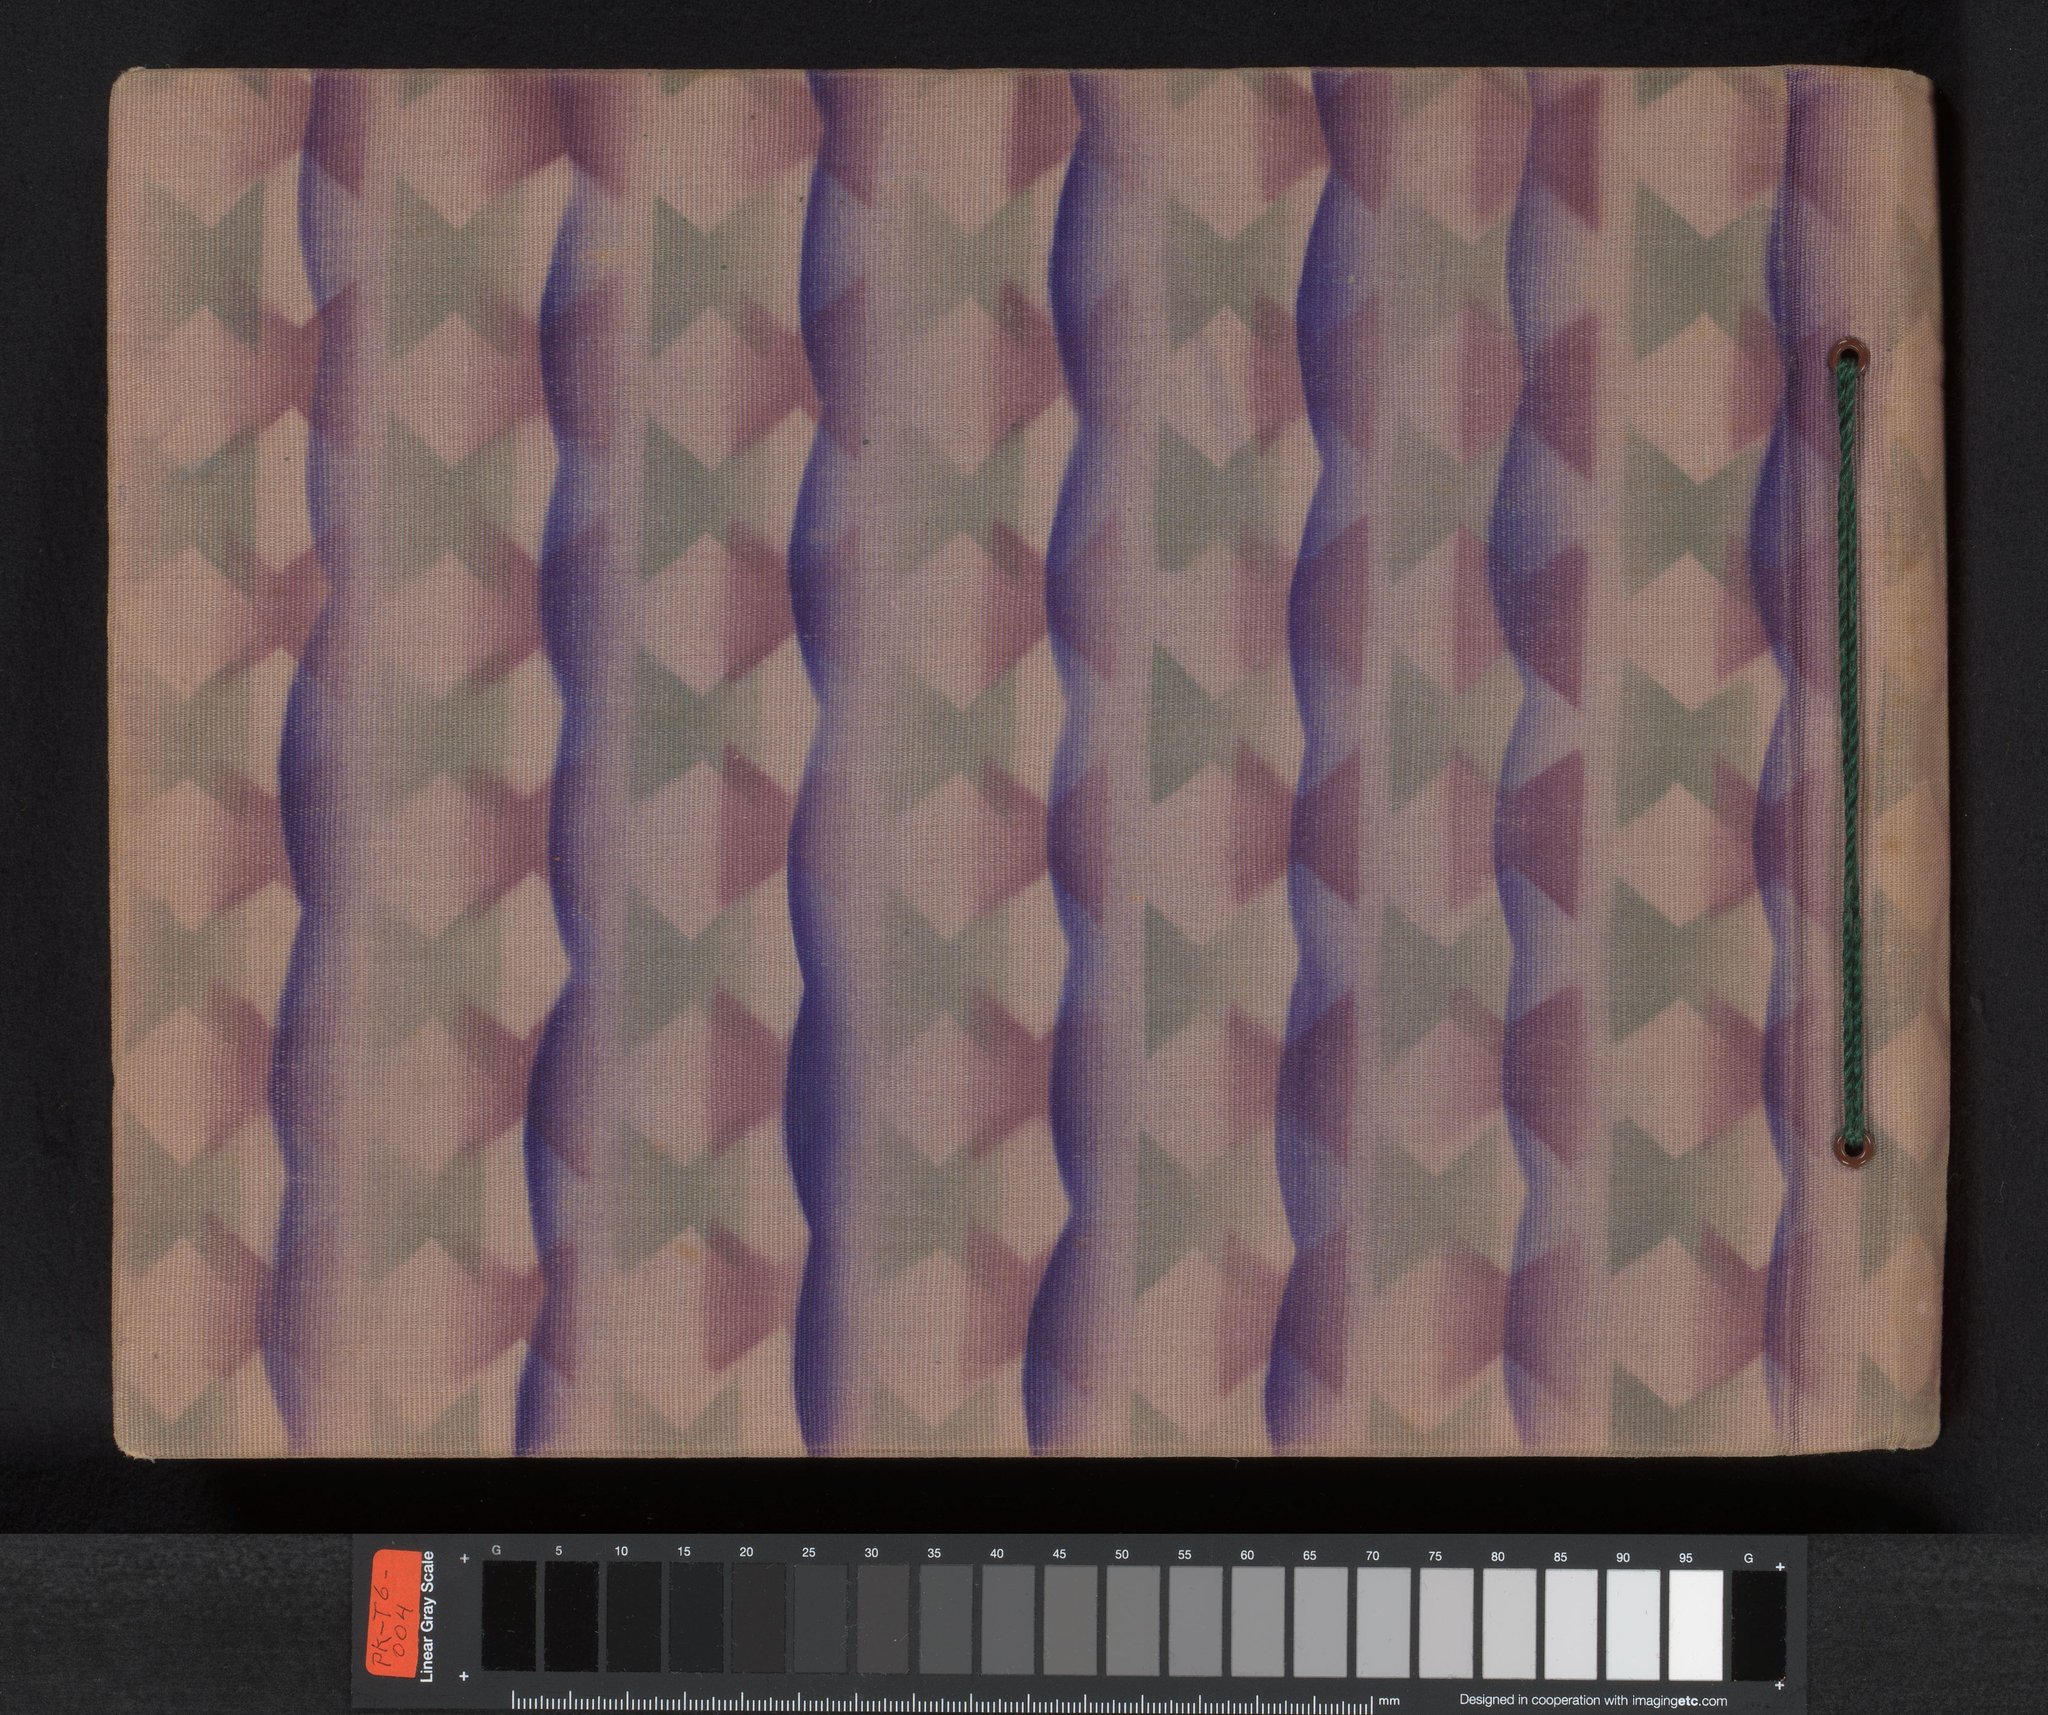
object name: album leaf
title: Echtpaar Berti Hoppe en Herman Besselaar in Lochem en Ruurlo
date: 1909-1932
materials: cardboard, paper, photographic support, plastic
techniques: gelatin silver print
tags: church (exterior), meadow, pasture (+ landscape with figures, staffage)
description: Vijf foto's gemaakt tijdens hun vakantie in Oost-Nederland in september 1932. Deze pagina maakt deel uit van een album.